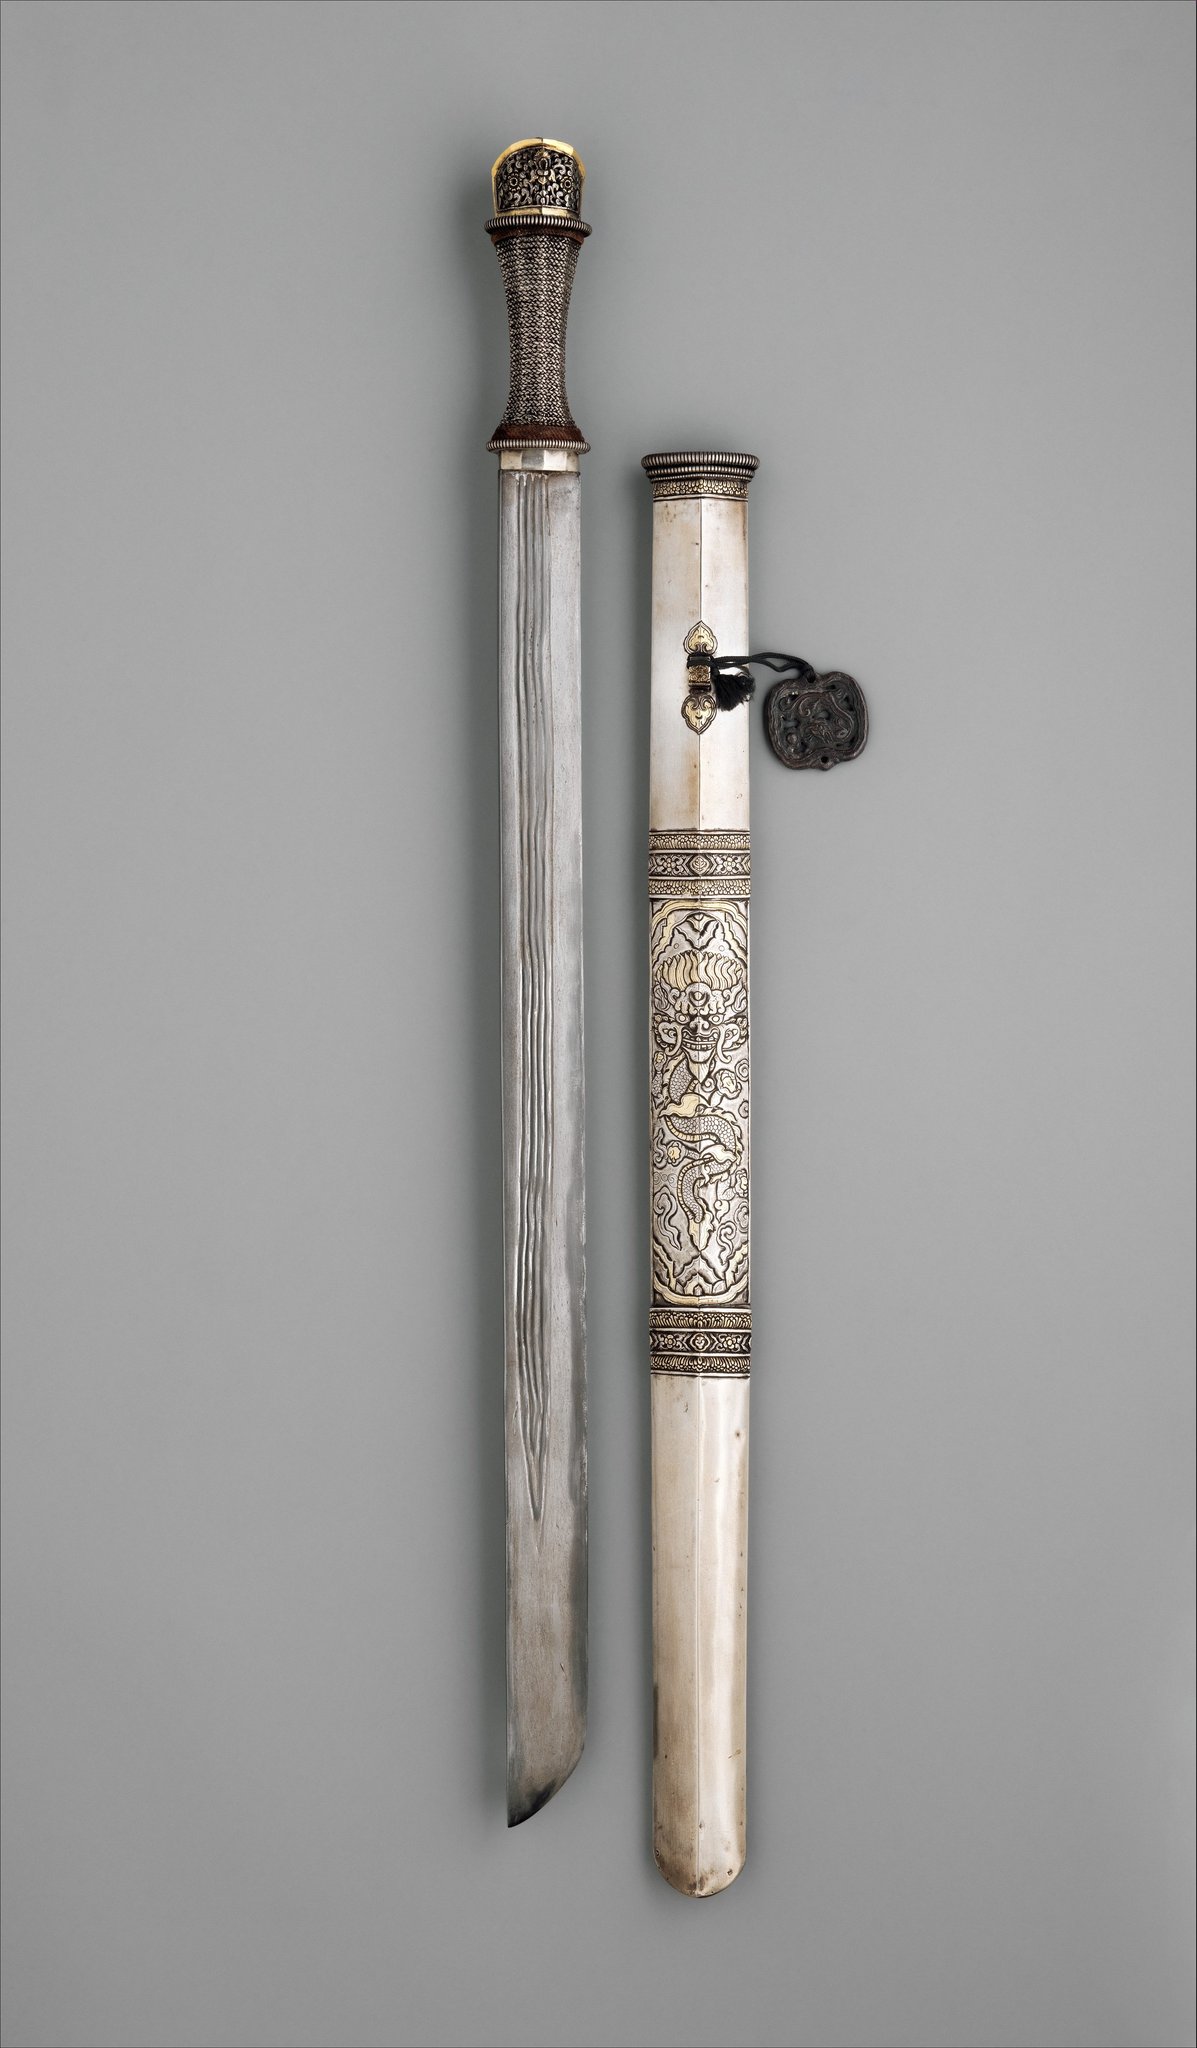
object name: sword and scabbard dpa rtags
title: Sword and Scabbard (dpa’ rtags)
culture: bhutanese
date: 1701-1900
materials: copper alloy, gold, silver, steel, wood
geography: bhutan